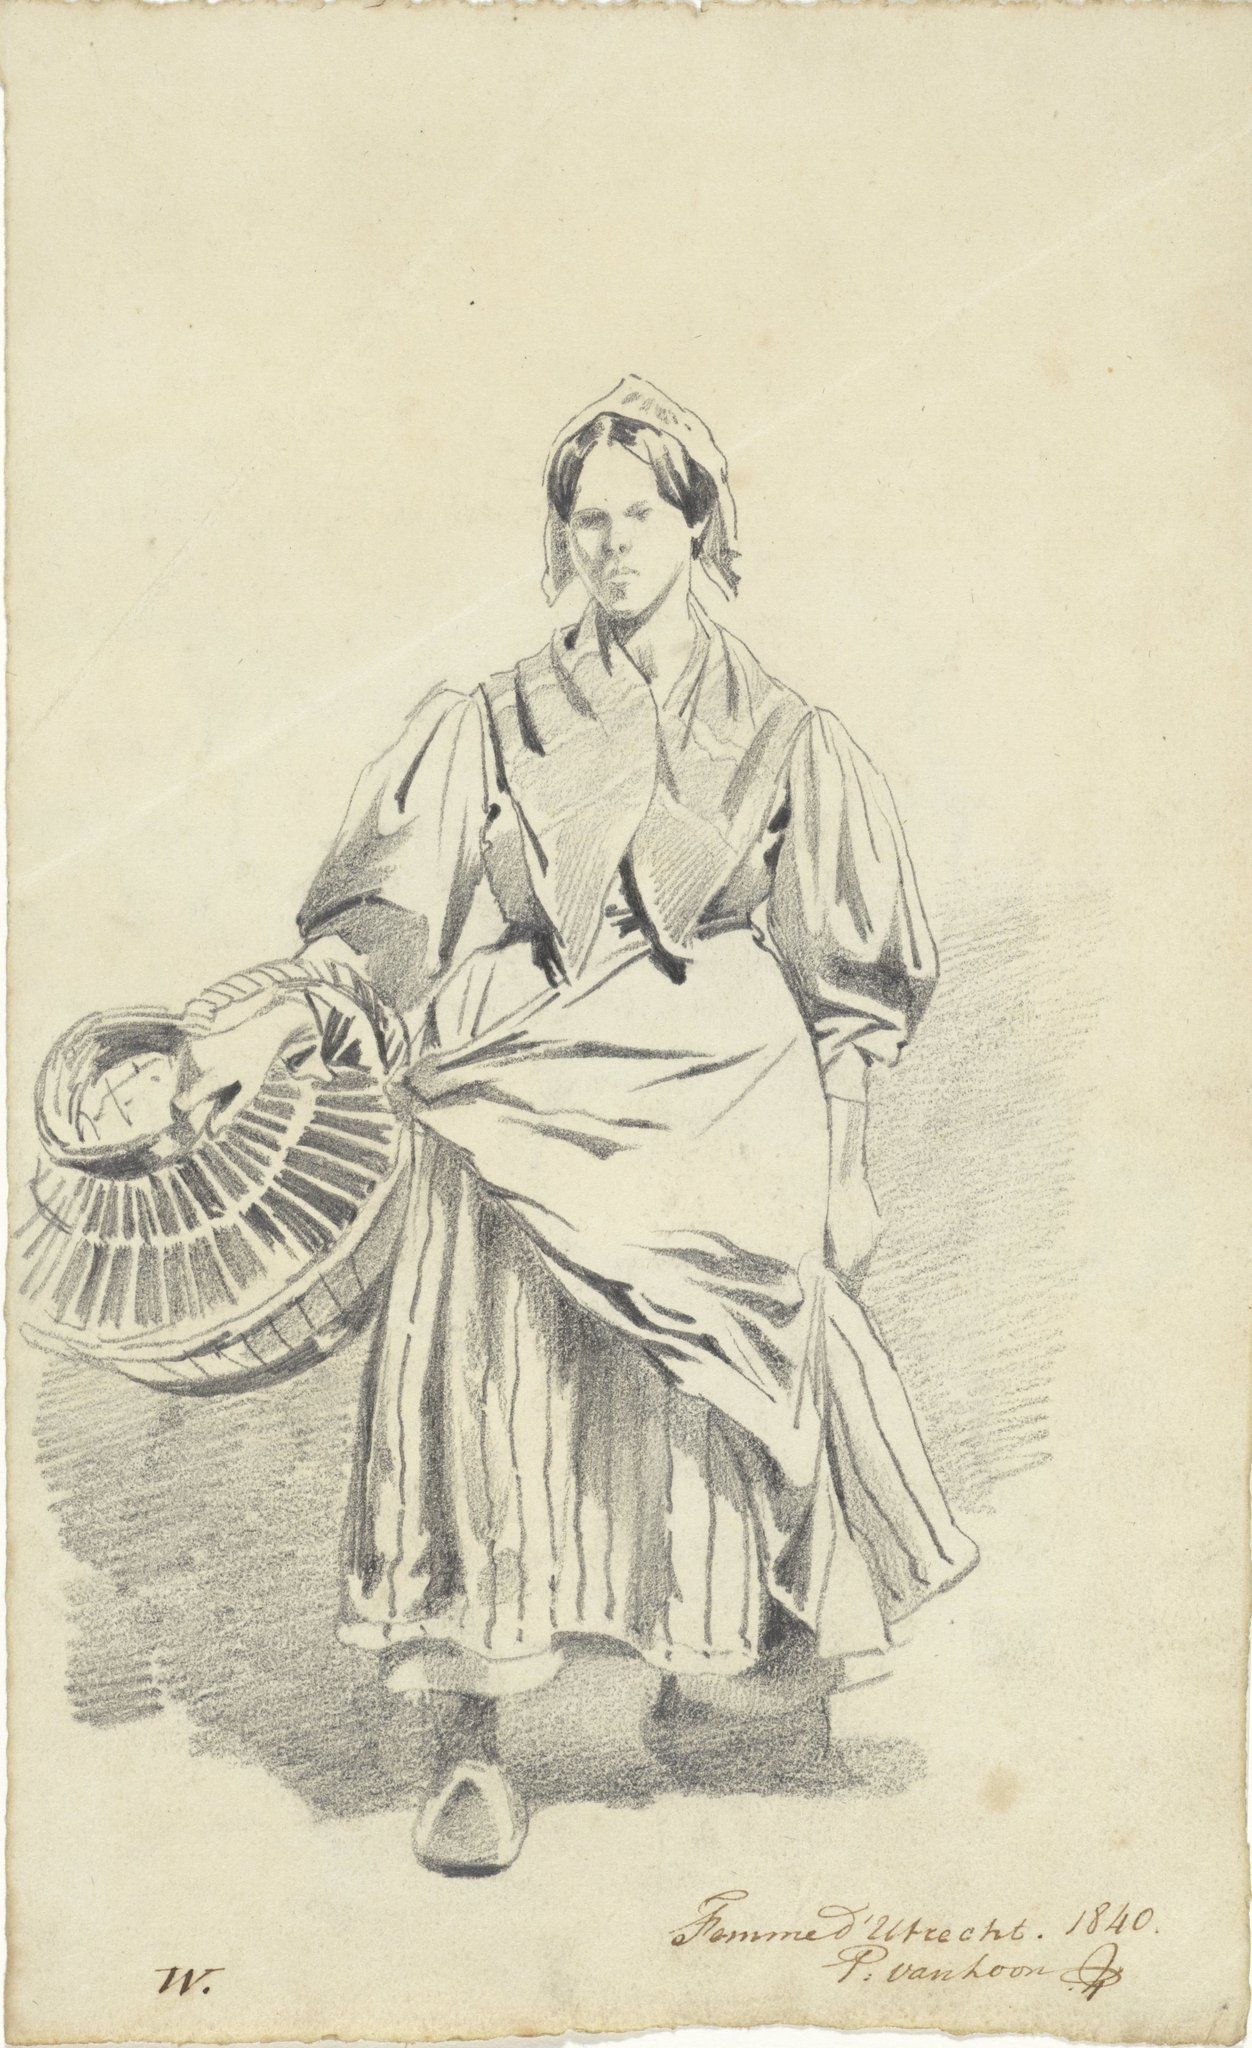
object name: drawing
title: Staande vrouw met mand, van voren gezien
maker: pieter van loon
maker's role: draughtsman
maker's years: 1801-1873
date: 1840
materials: paper, pencil